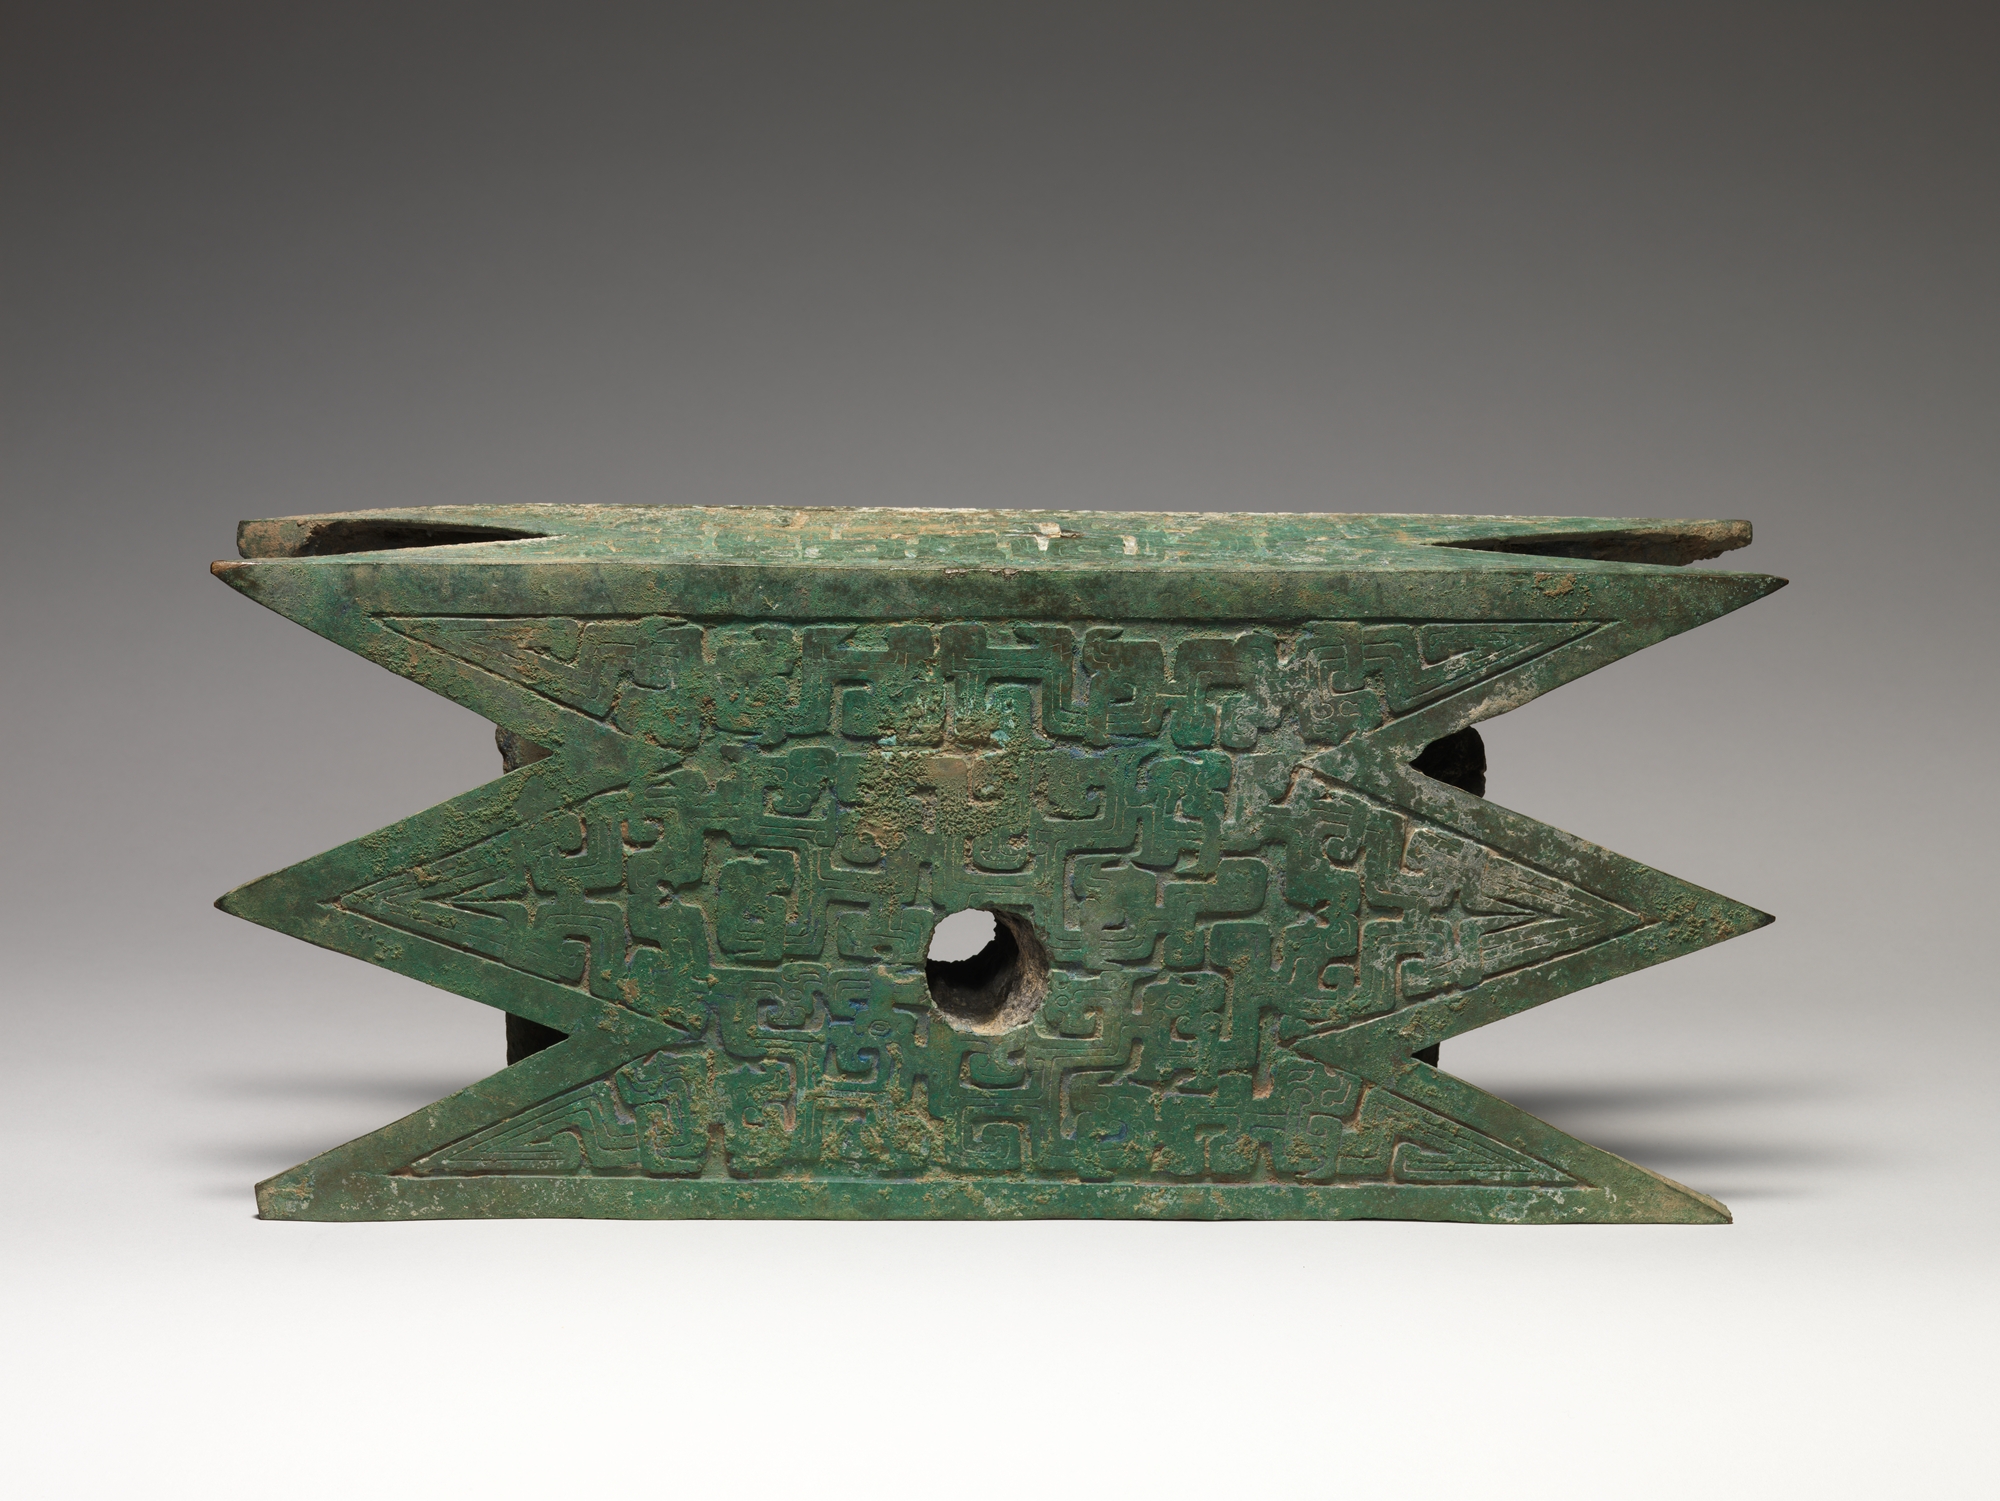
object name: architectural unit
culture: chinese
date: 1046-256 BCE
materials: bronze, patina